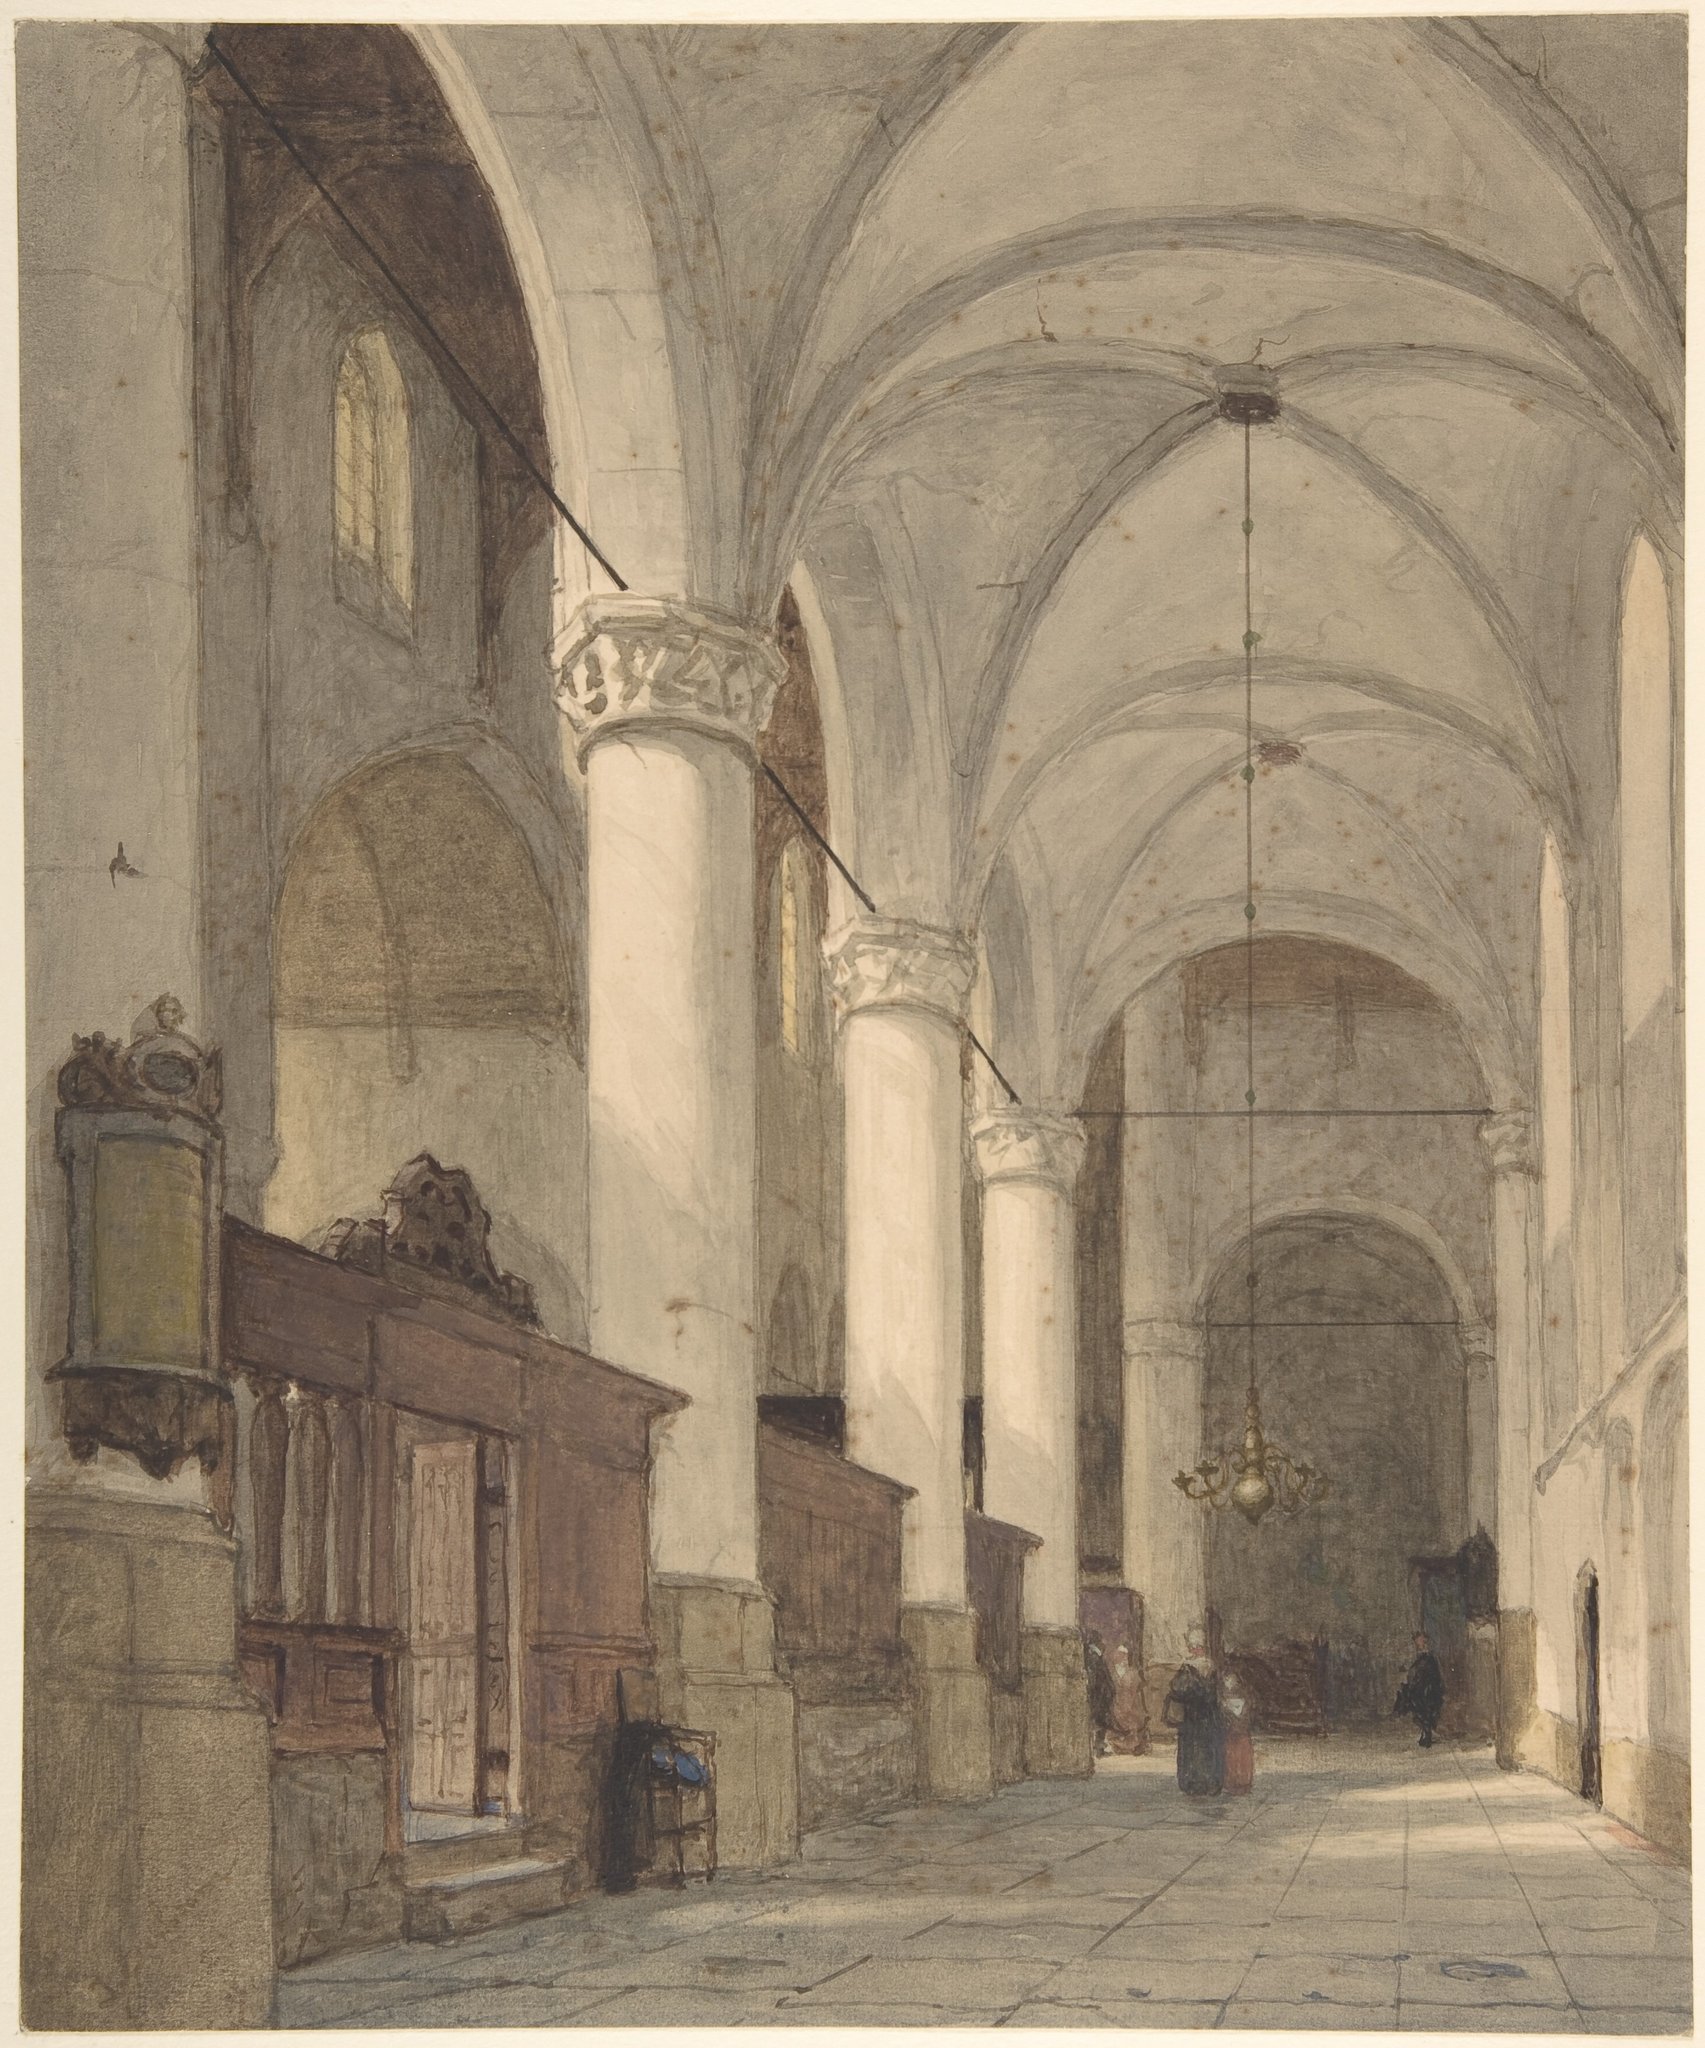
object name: drawing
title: Vaulted Side Aisle of a Church, with Figures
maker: johannes bosboom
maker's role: artist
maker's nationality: dutch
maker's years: 1817-1891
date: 1801-1900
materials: ink, watercolor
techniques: brush, pen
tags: interiors,churches